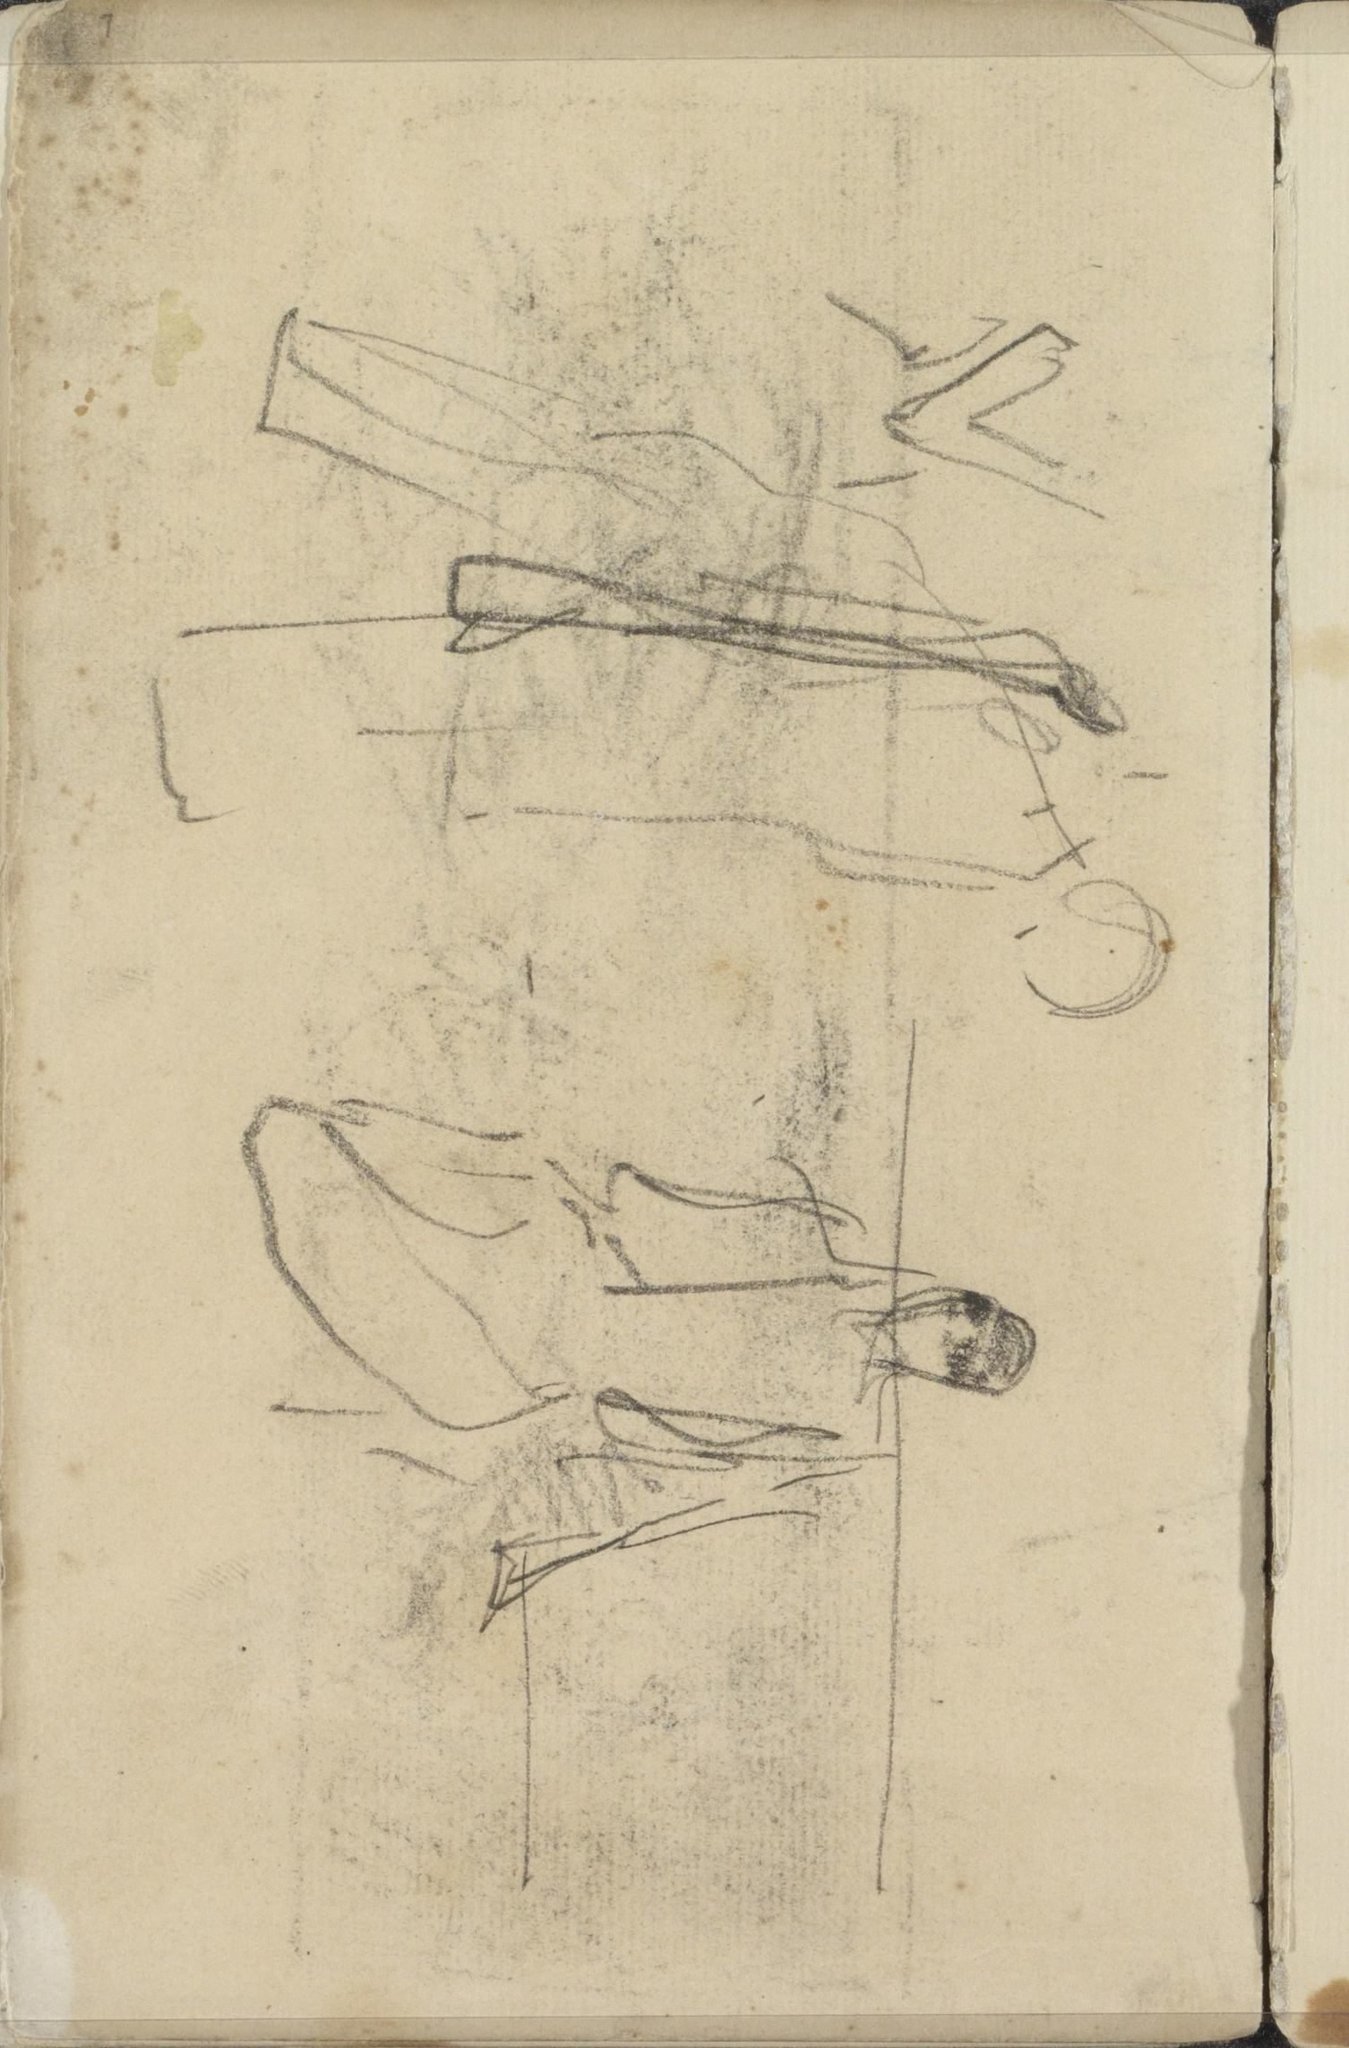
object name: sketchbook leaf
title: Figuurstudies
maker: george hendrik breitner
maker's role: draughtsman, painter, print maker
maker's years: 1857-1923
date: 1883-1884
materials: chalk, paper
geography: the hague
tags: adult woman, adult man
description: Pagina 7 uit een schetsboek met 23 bladen.